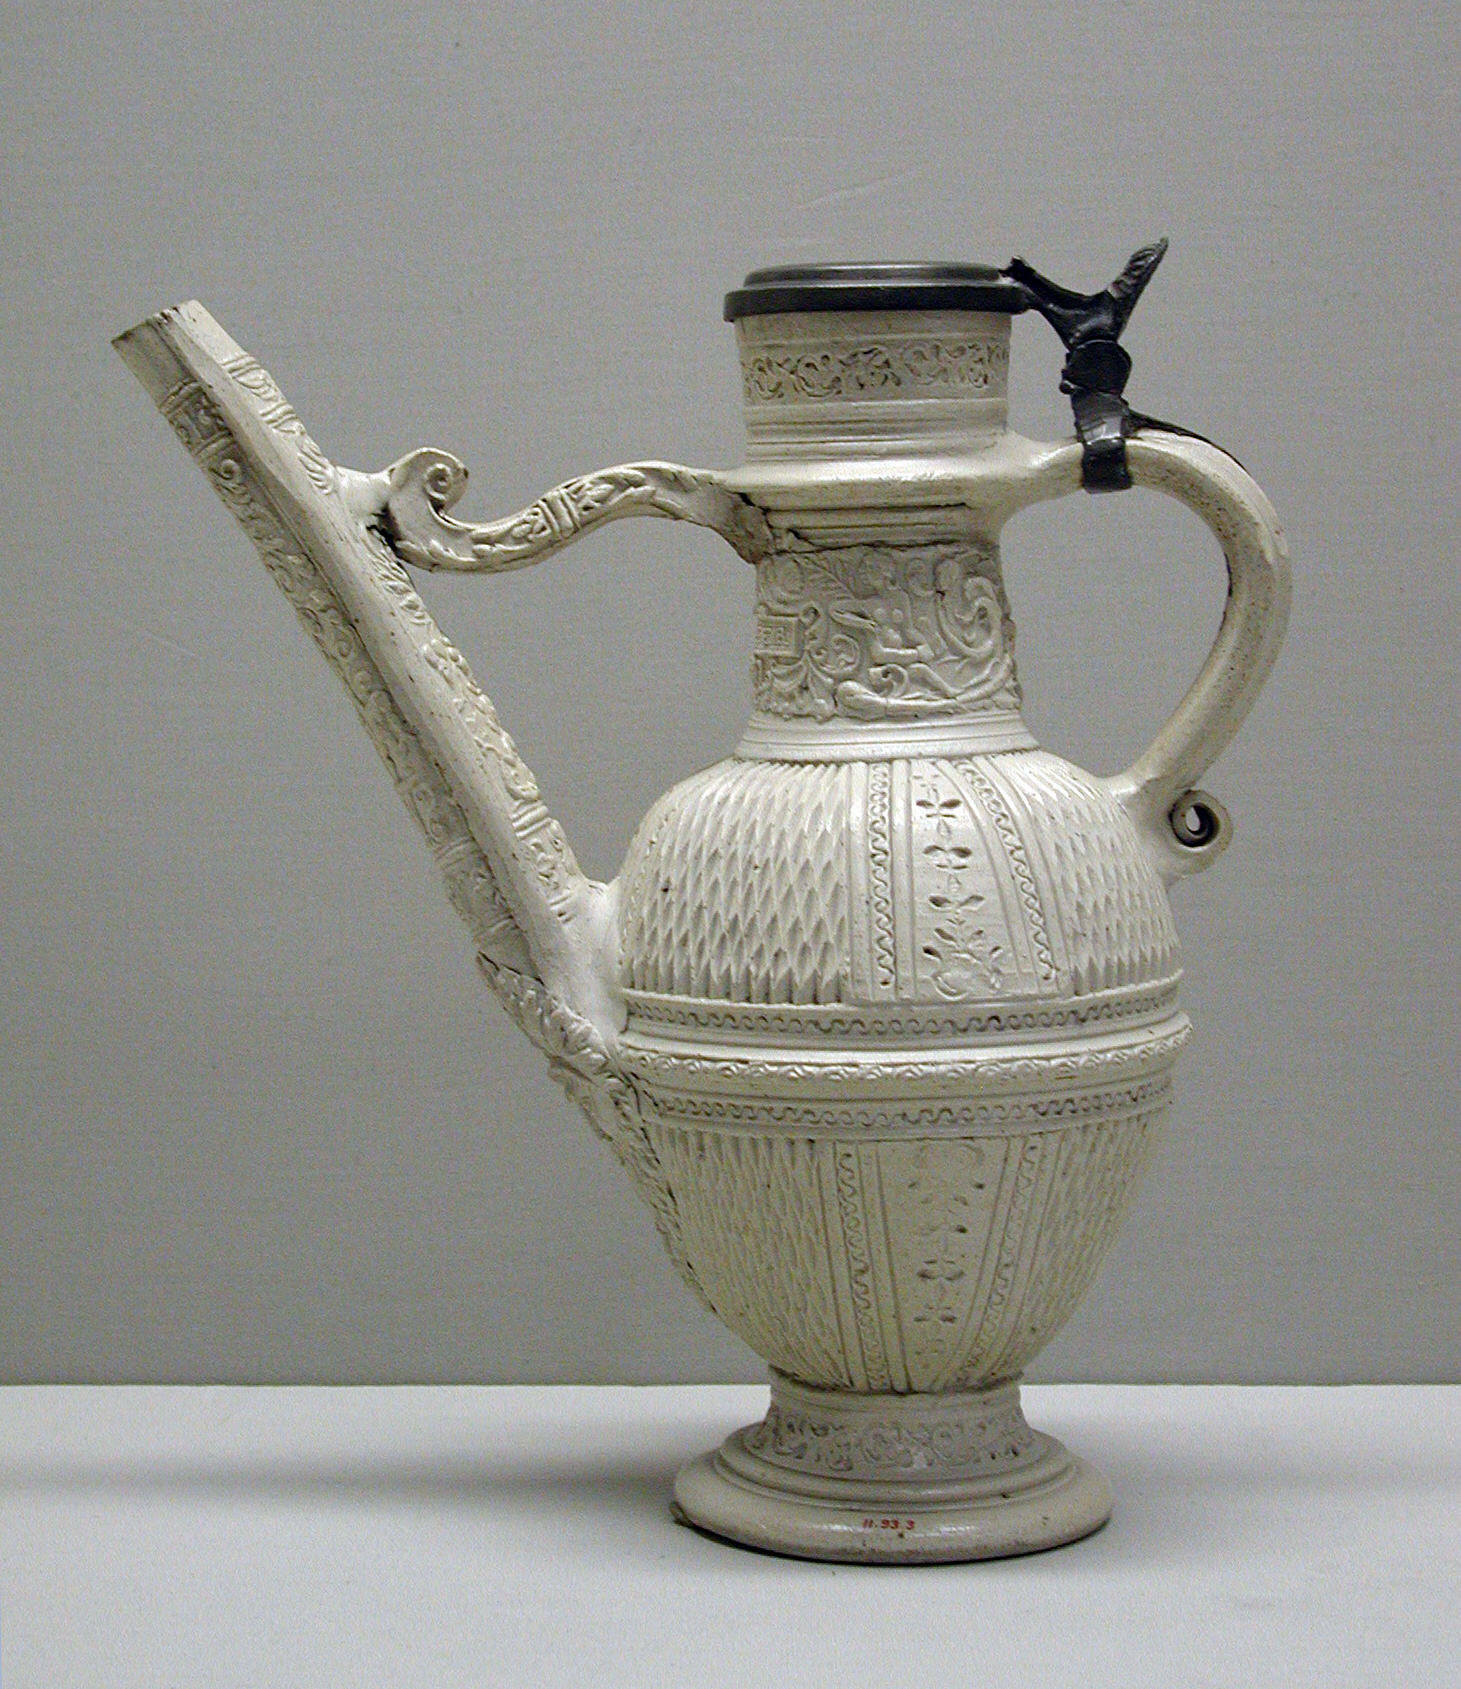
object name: ewer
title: Ewer (Schnabelkanne)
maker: theodor de bry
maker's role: decorator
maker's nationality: netherlandish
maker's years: 1528-1598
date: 1595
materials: pewter, stoneware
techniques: glazing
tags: faces,female nudes